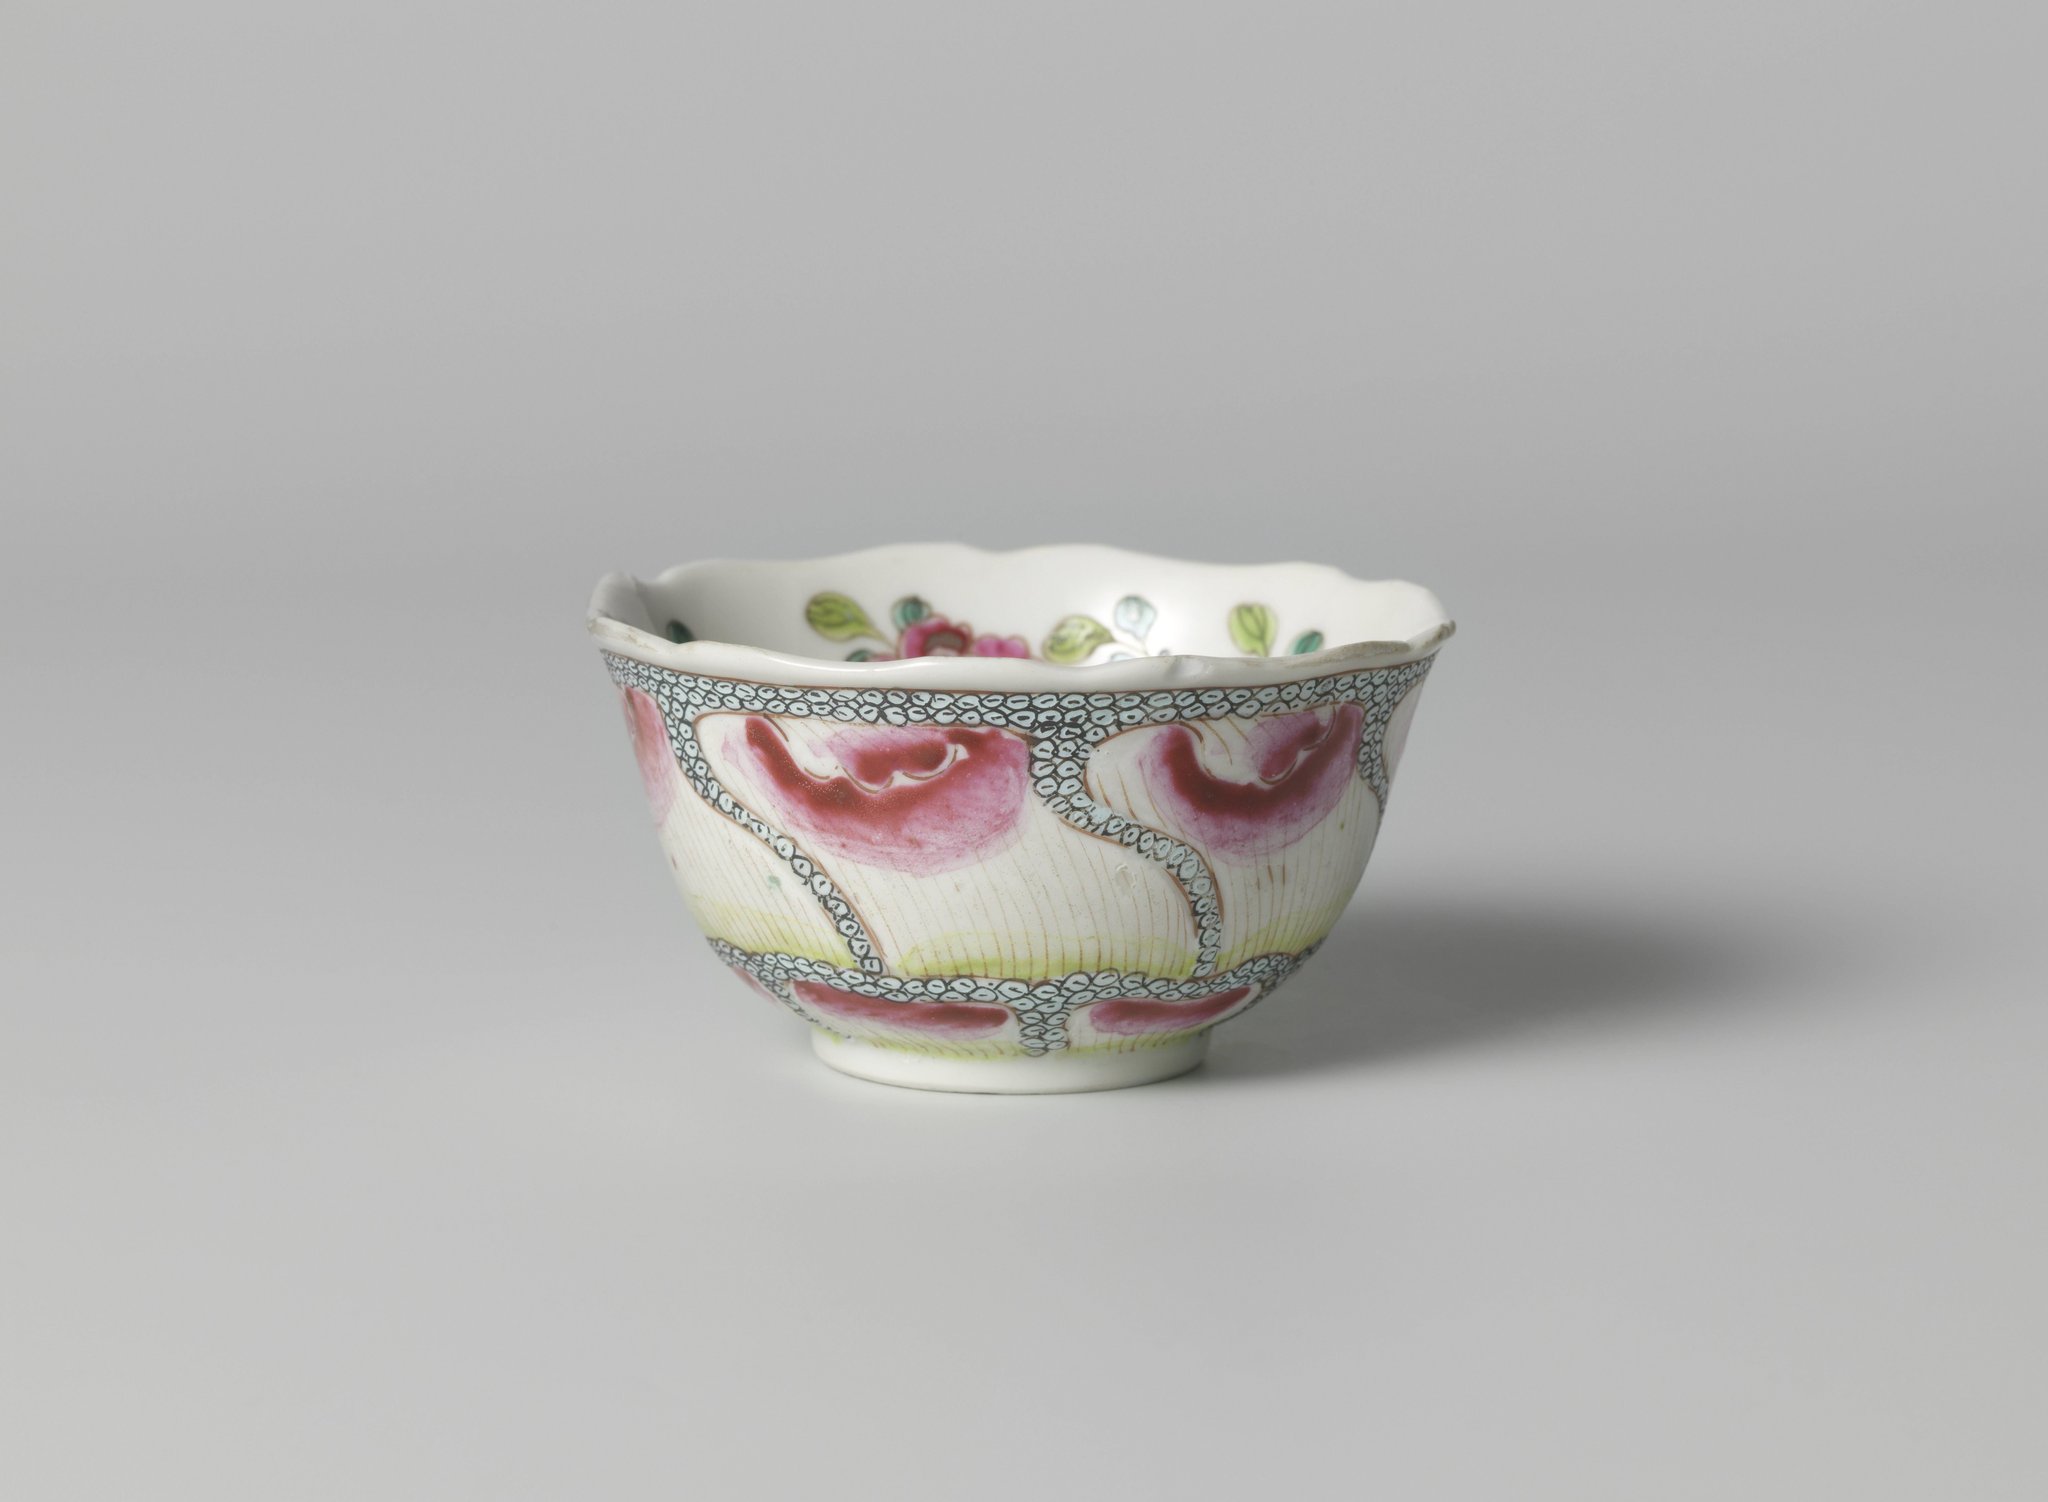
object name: kop en schotel, kop en schotel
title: Bell-shaped cup with undulating flower petals on diaper pattern and flower sprays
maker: Anonymous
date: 1840-1860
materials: glaze, paint, porcelain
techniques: firing, turning, vitrification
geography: china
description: Klokvormige kop van porselein met gelobde rand, beschilderd op het glazuur in blauw, rood, roze, groen en zwart. In het centrum een bloem met daaromheen twee rijen met golvende bloembladeren op een grond van servetwerk afgebeeld; de buitenzijde van de kop met drie bloemtakken. Famille rose.